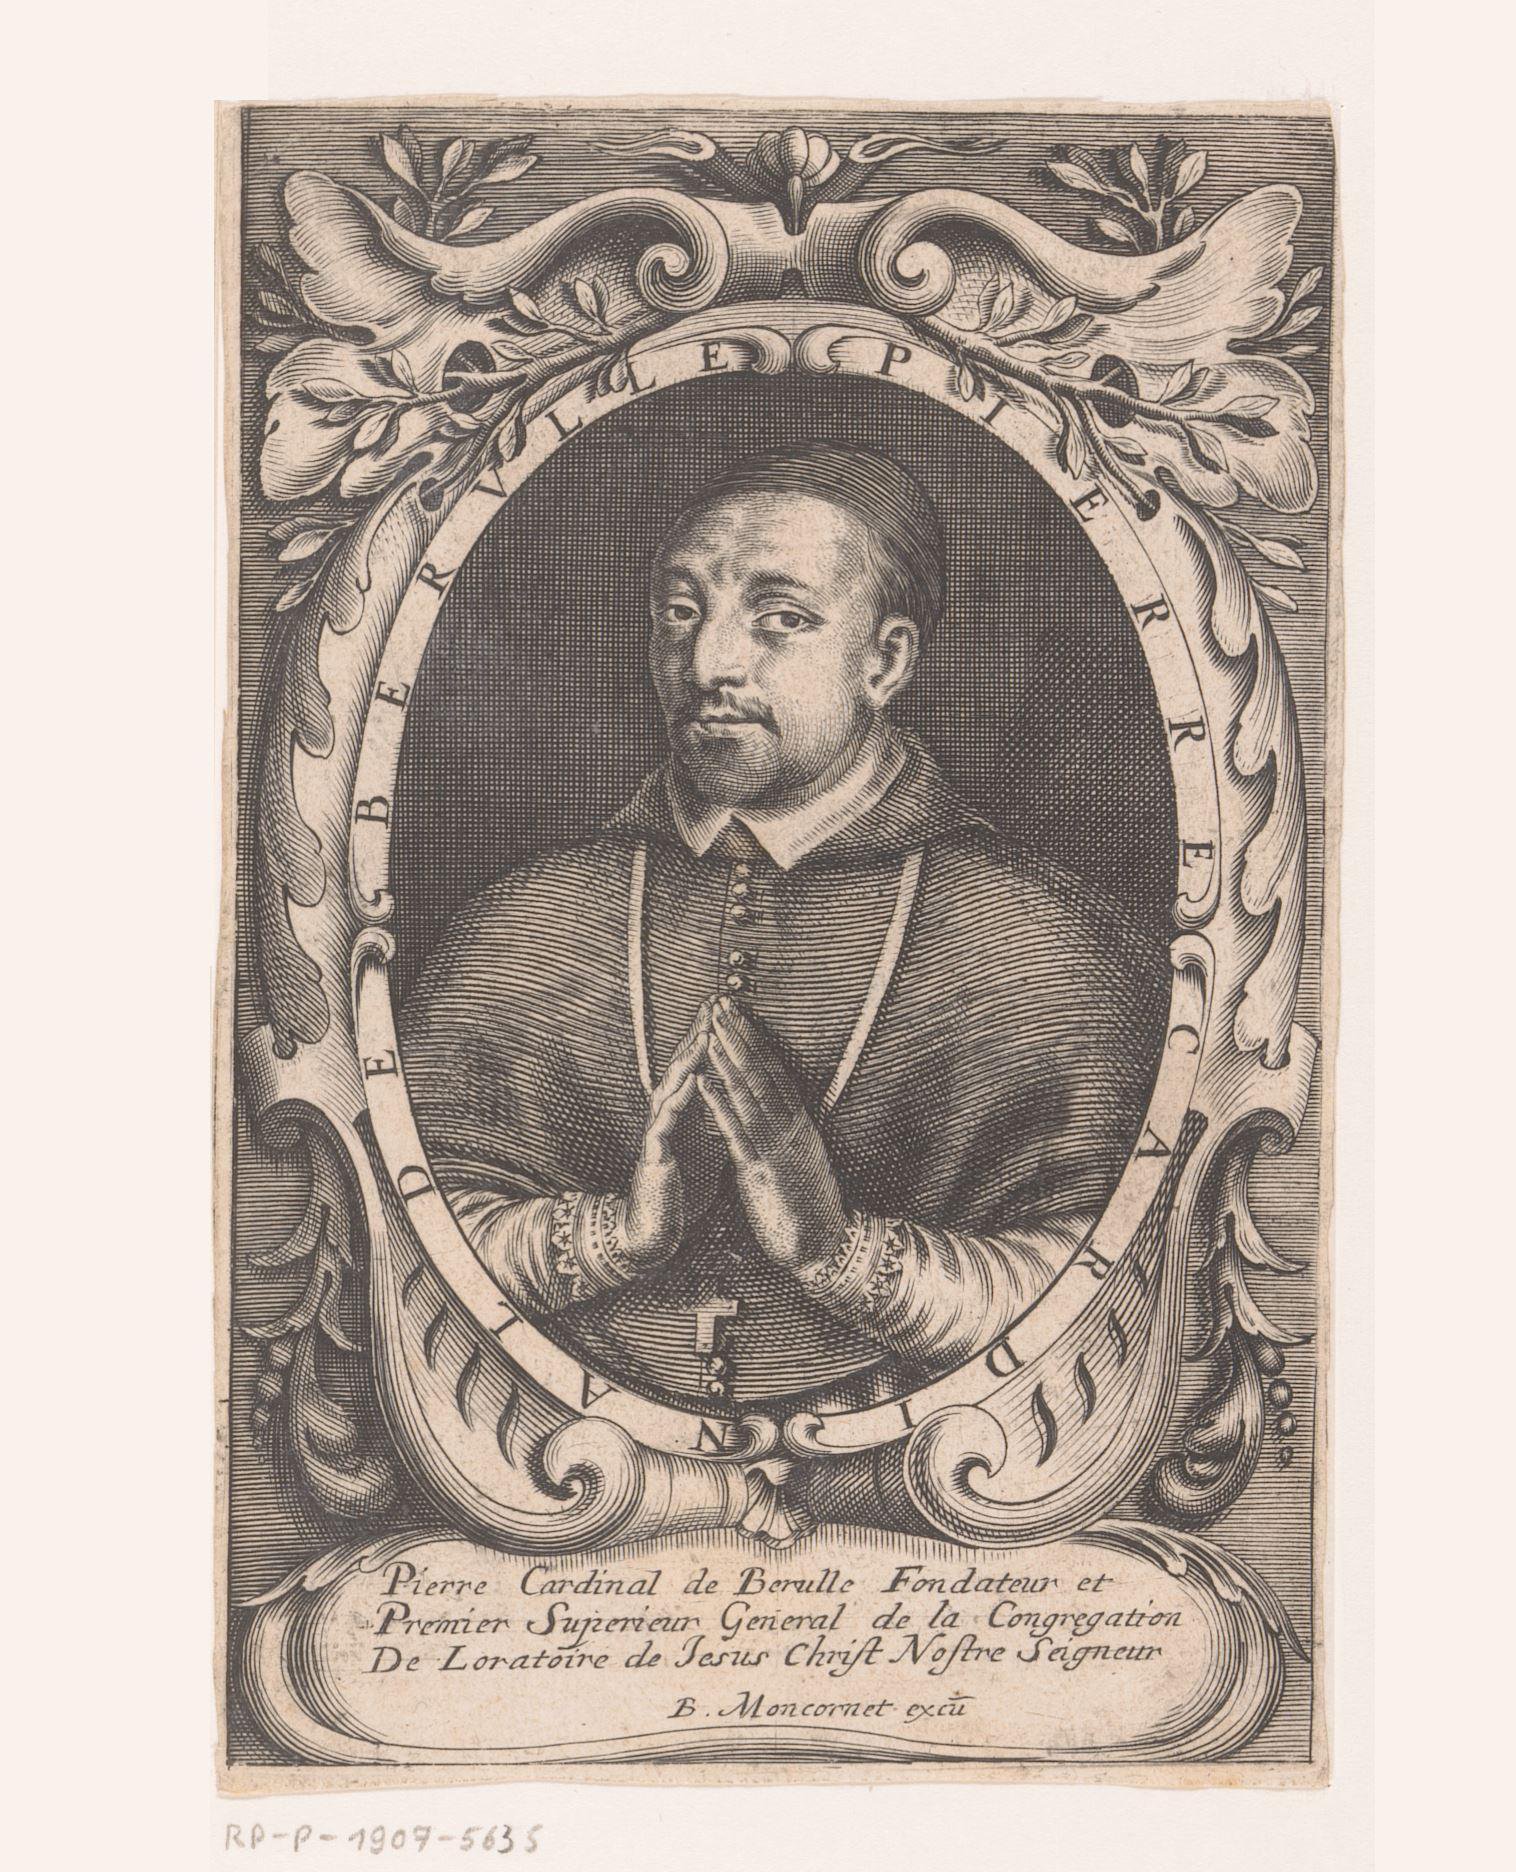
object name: print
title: Portret van Pierre de Bérulle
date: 1610-1668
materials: paper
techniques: engraving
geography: paris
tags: priest (roman catholic), historical persons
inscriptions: collector's mark: Lugt 2228